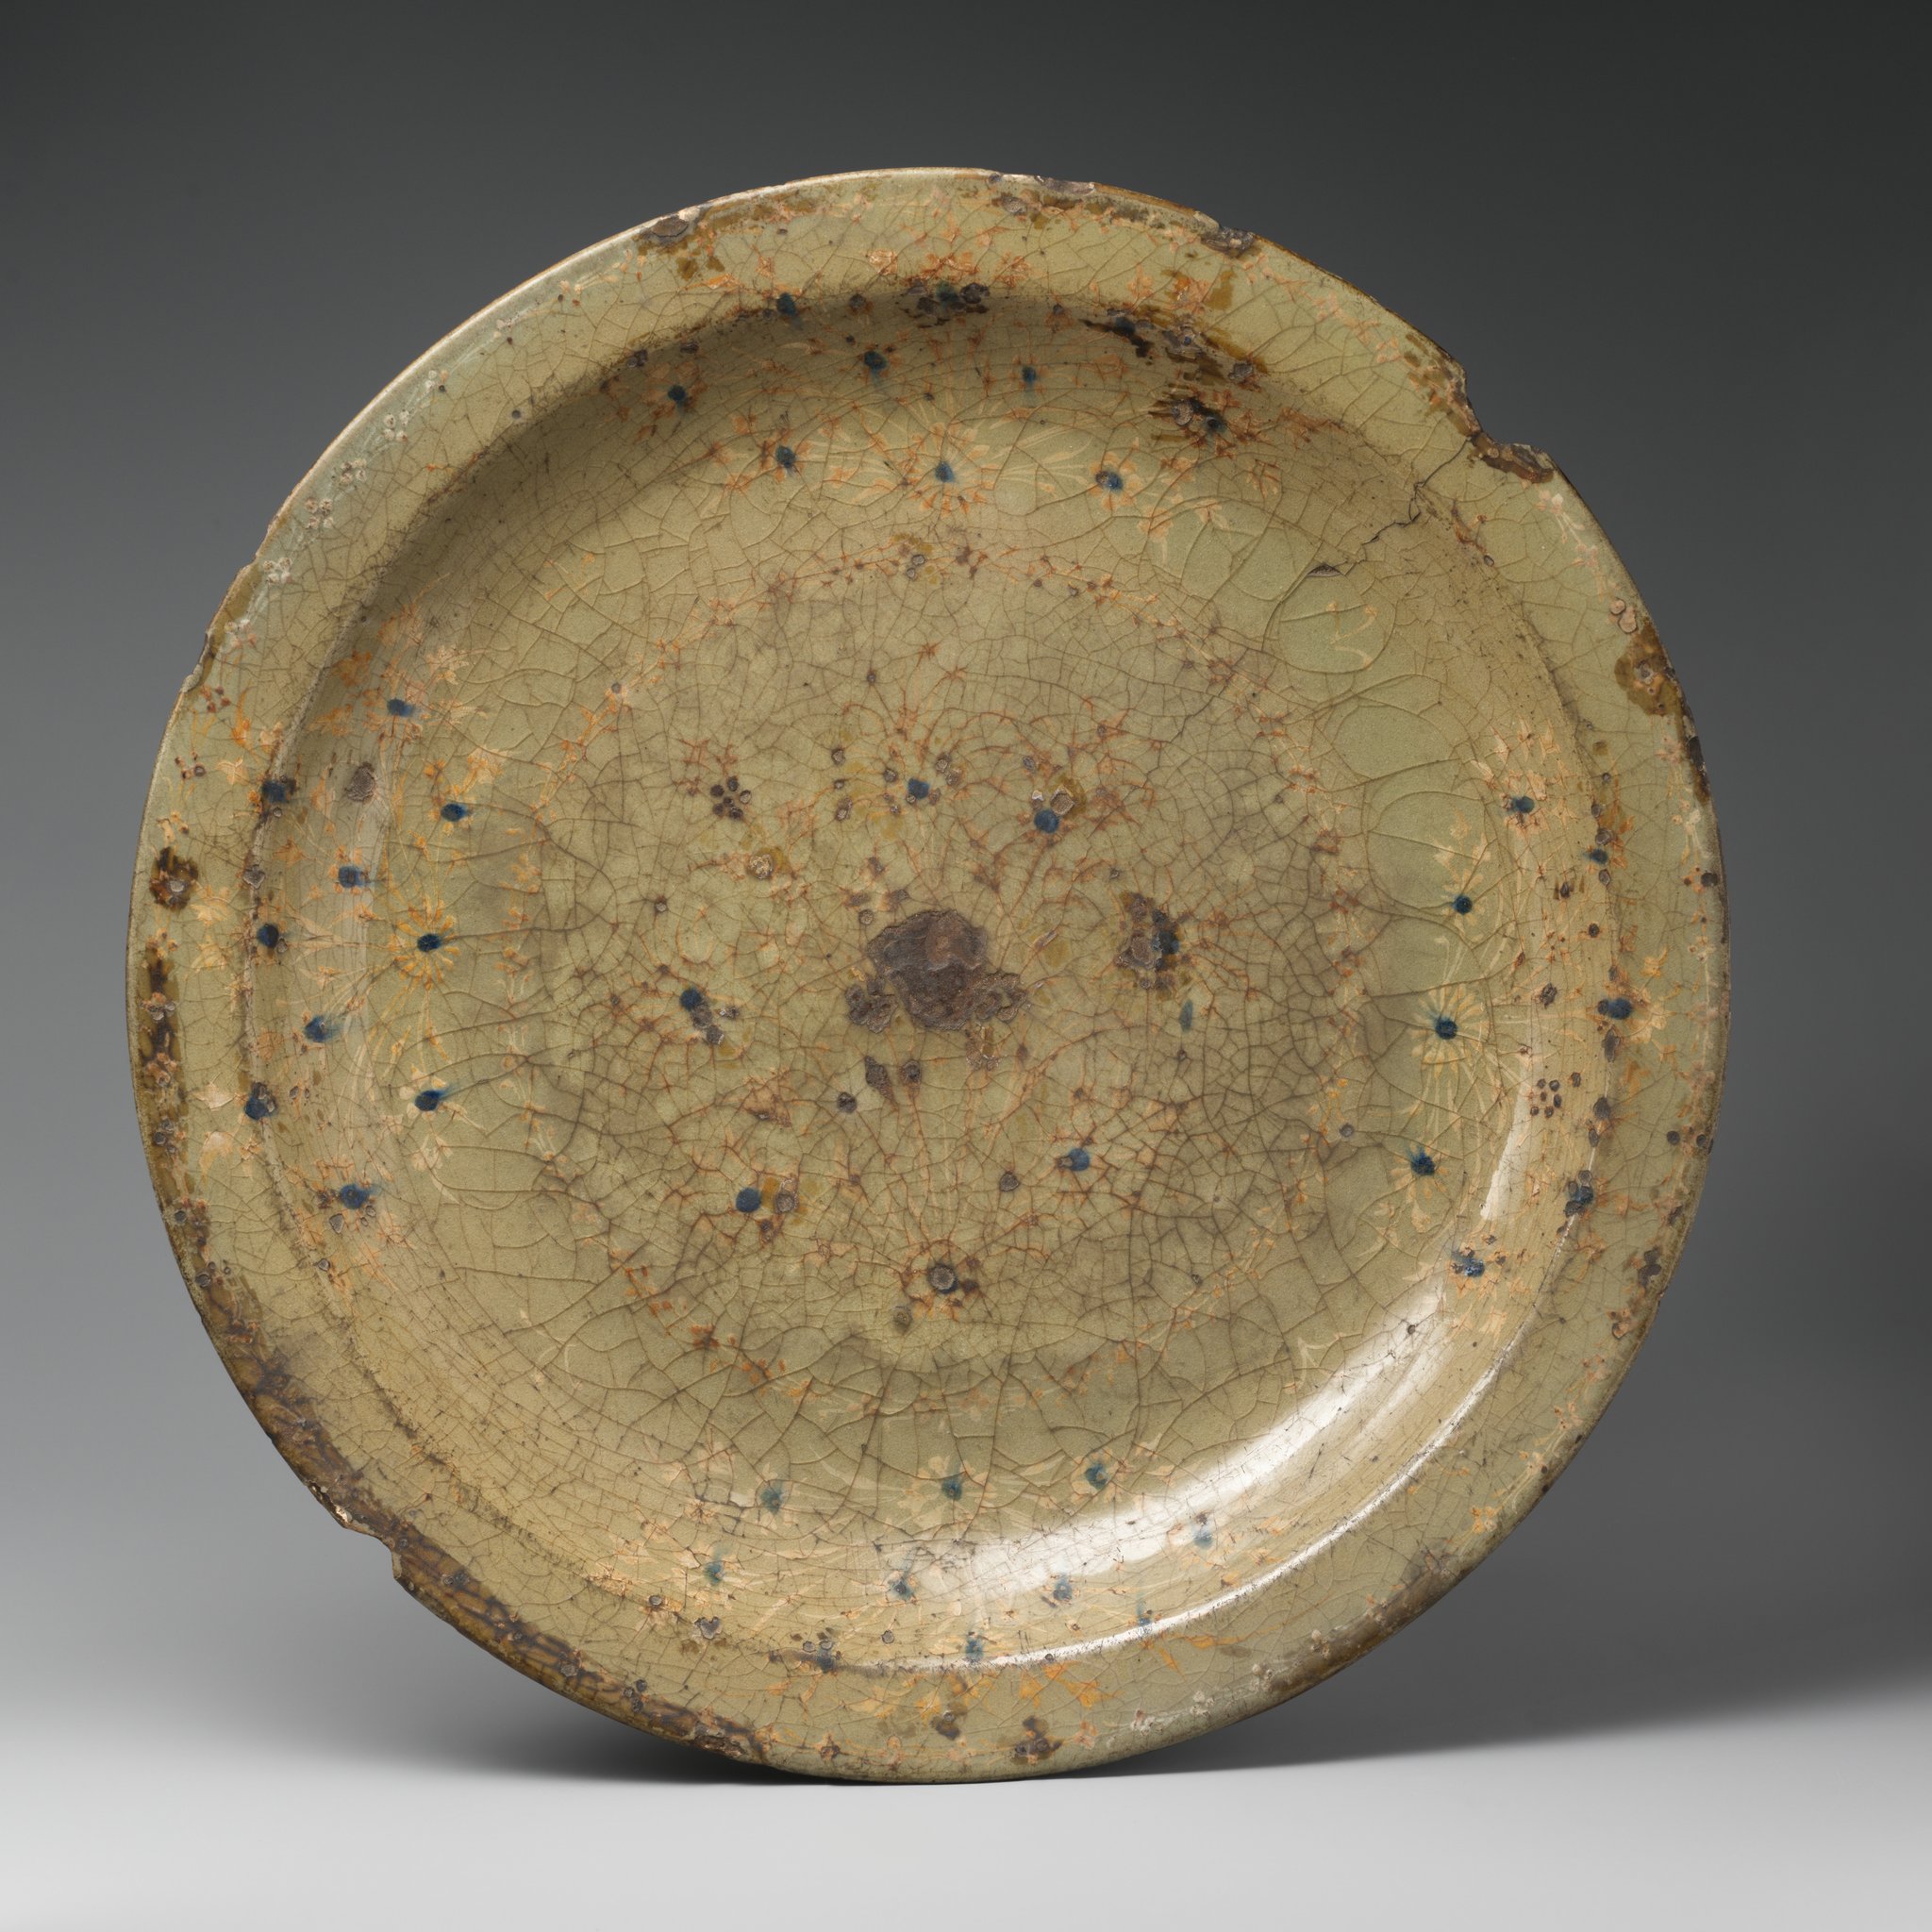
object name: dish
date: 1701-1800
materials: stonepaste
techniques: glazing, painting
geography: kerman